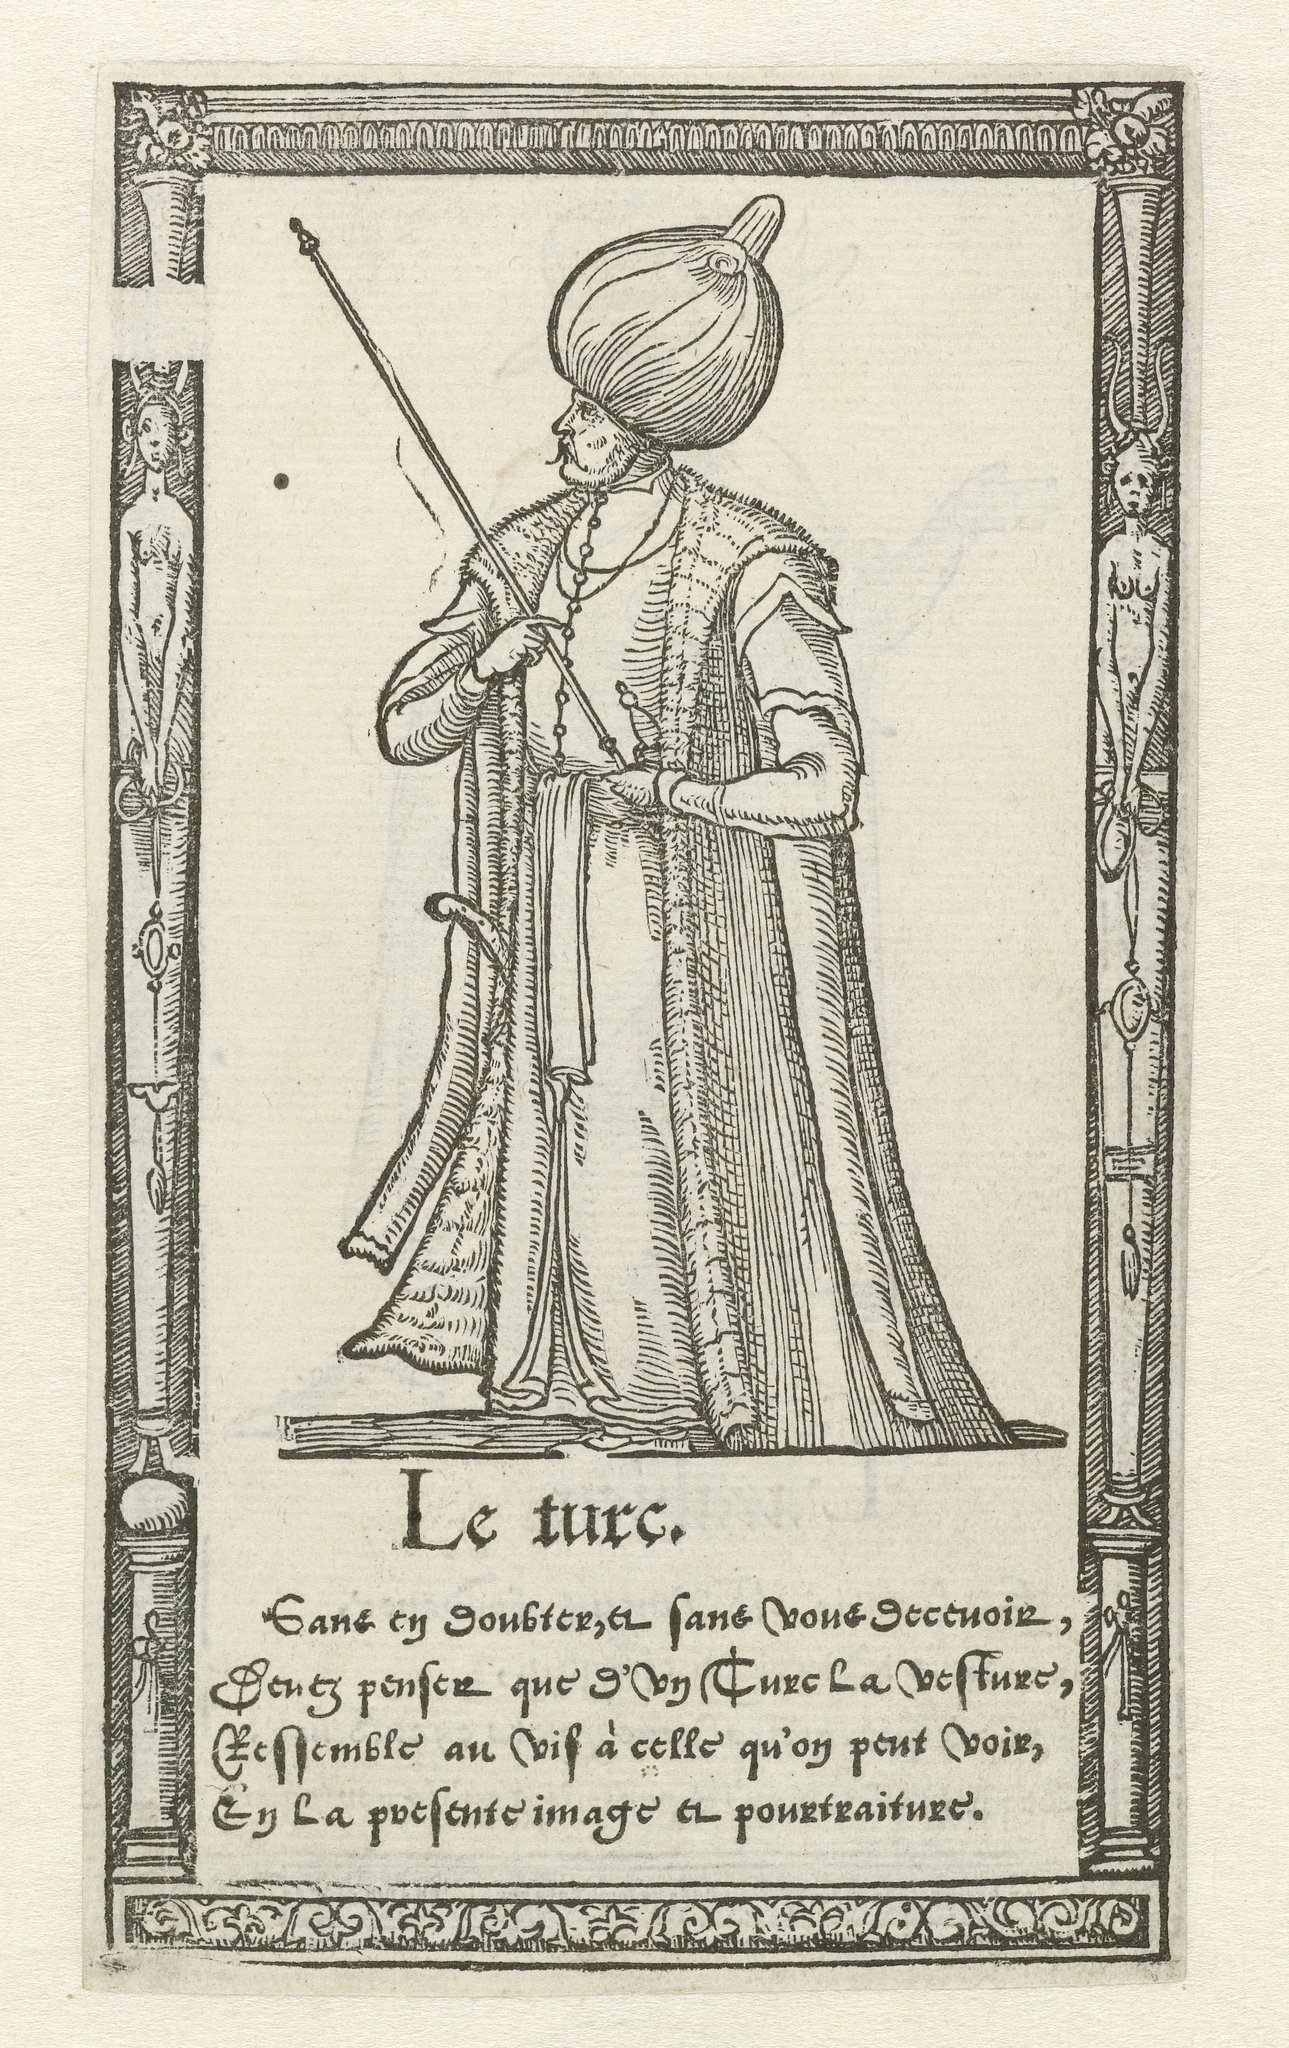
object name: print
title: Recueil de la diversité des habits (A Collection of the Various Styles of Clothing)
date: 1562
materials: paper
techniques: woodcut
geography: paris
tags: asiatic races and peoples (+ costume), fashion plates, head-gear: turban, folk costume, regional costume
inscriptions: collector's mark: Lugt 2228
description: This is the very first costume book, with more than a hundred images of clothing from around the world. Below each figure are four lines of verse describing the country’s outfits or related customs. This was an age of unprecedented overseas exploration. Europeans were especially fascinated to see and read about inhabitants of the so-called New World, such as the Brazilian woman with her child 1.